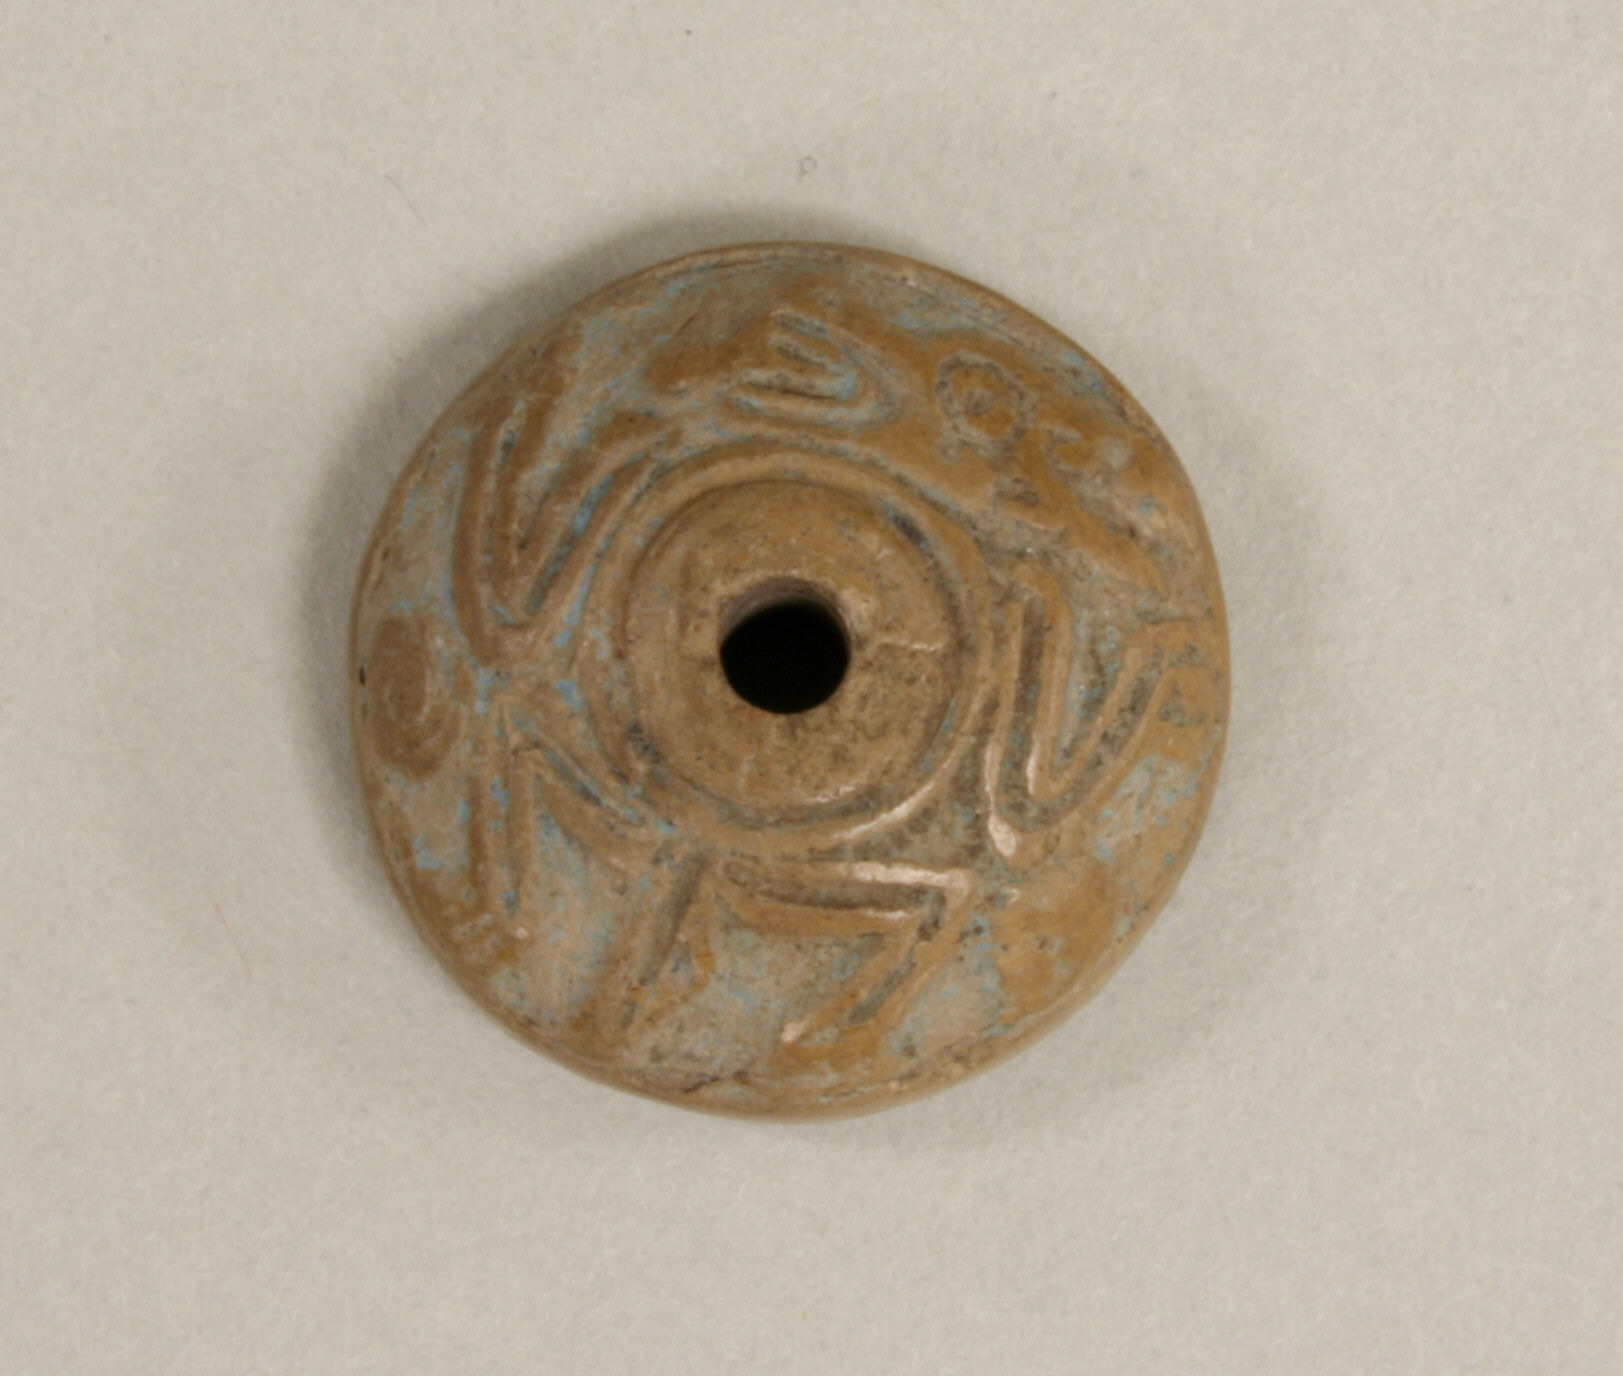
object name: spindle whorl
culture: mexican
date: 801-1500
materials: ceramic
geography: mexico